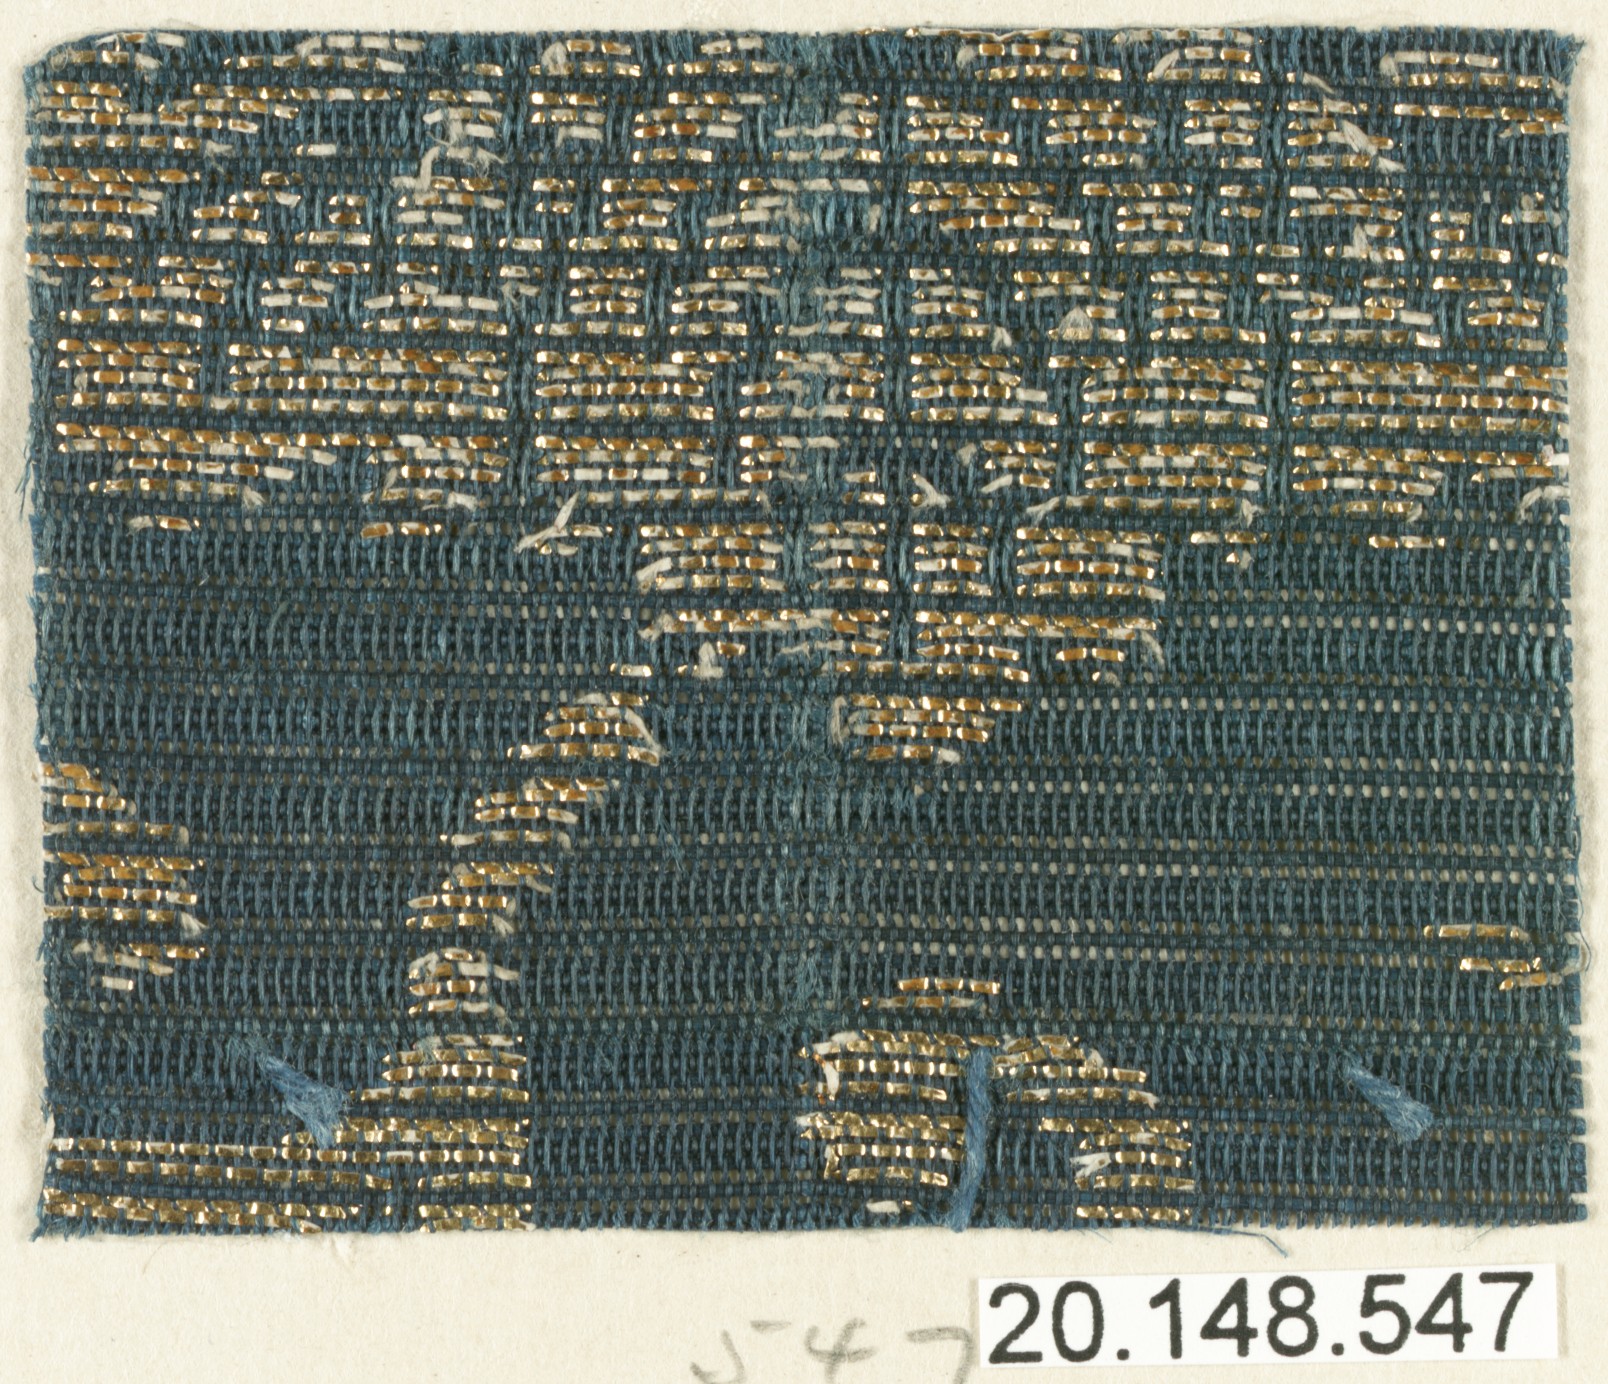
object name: piece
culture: chinese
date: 1701-1800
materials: silk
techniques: compound weave